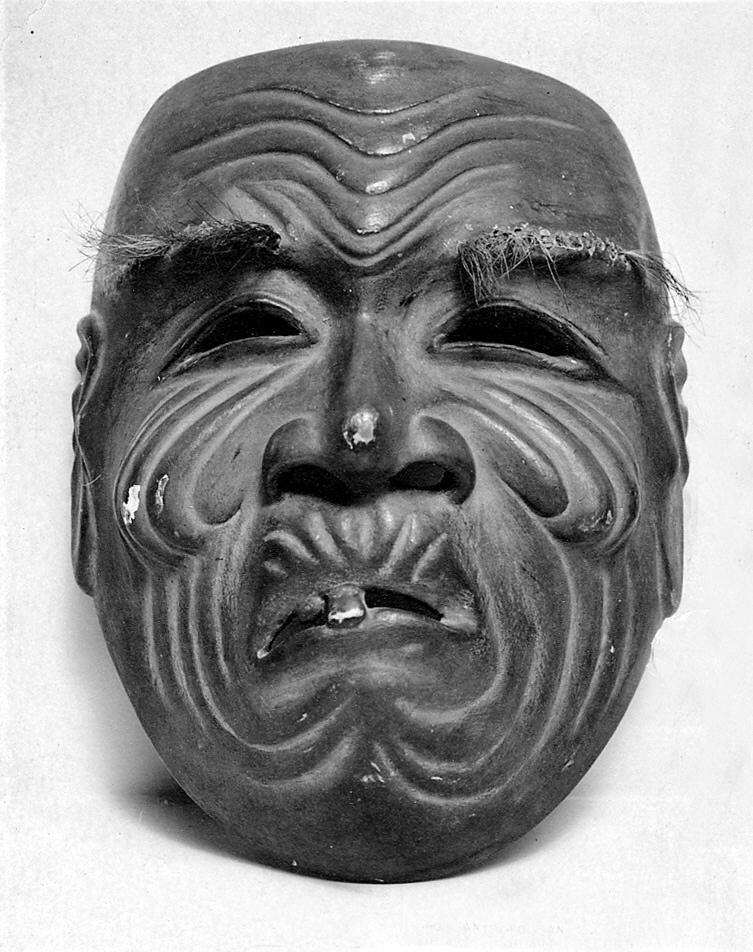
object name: kyogen mask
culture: japanese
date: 1701-1800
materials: wood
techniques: brocade, carving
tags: masks